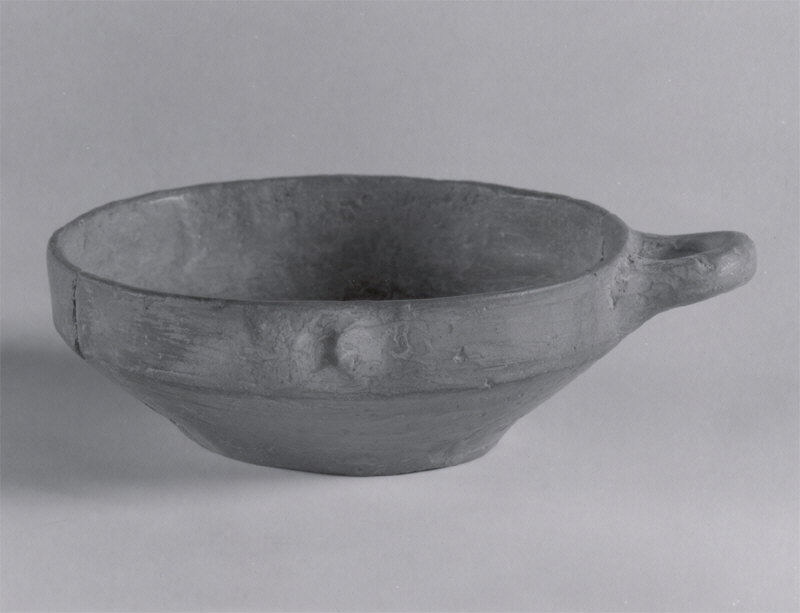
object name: bowl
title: Shallow bowl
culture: iranian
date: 700-601 BCE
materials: ceramic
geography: iran